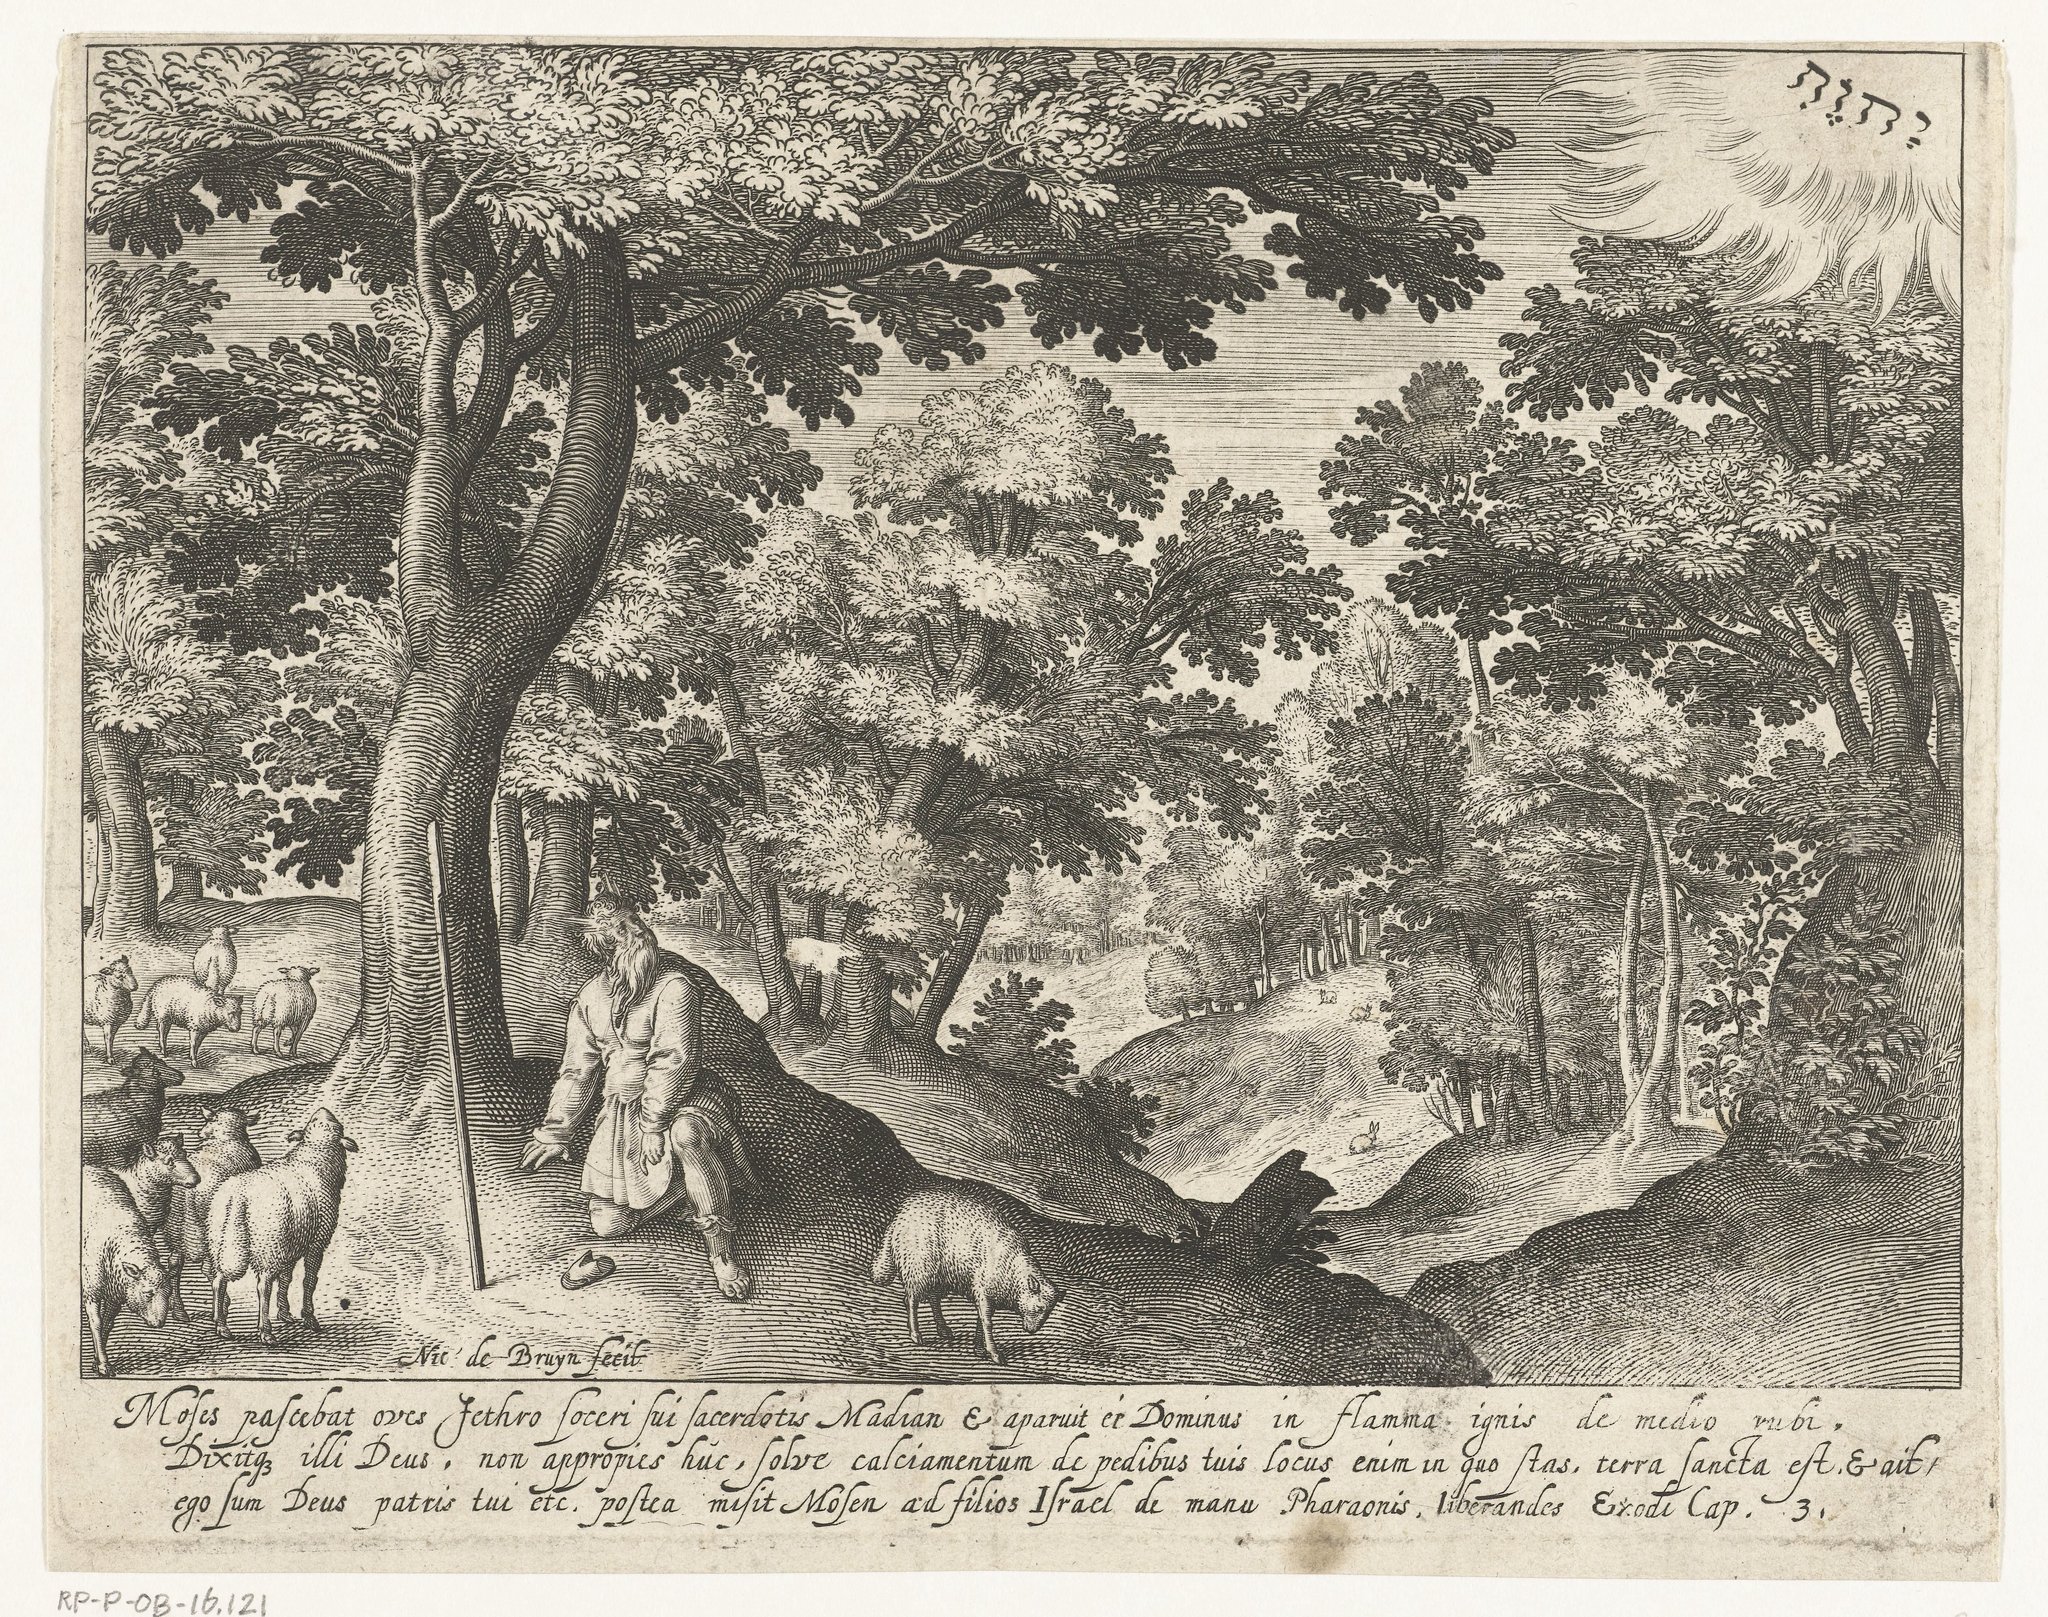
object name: print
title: God verschijnt aan Mozes op de berg Horeb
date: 1581-1656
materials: paper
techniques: engraving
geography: netherlands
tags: moses taking off his sandals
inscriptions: collector's mark: Lugt 2228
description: Mozes hoedt een kudde schapen op de berg Horeb. Hij wordt aangesproken door God en trekt zijn sandalen uit om respect te tonen voor de heilige grond. In de marge onder een bijbeltekst in Latijn uit Exodus 3